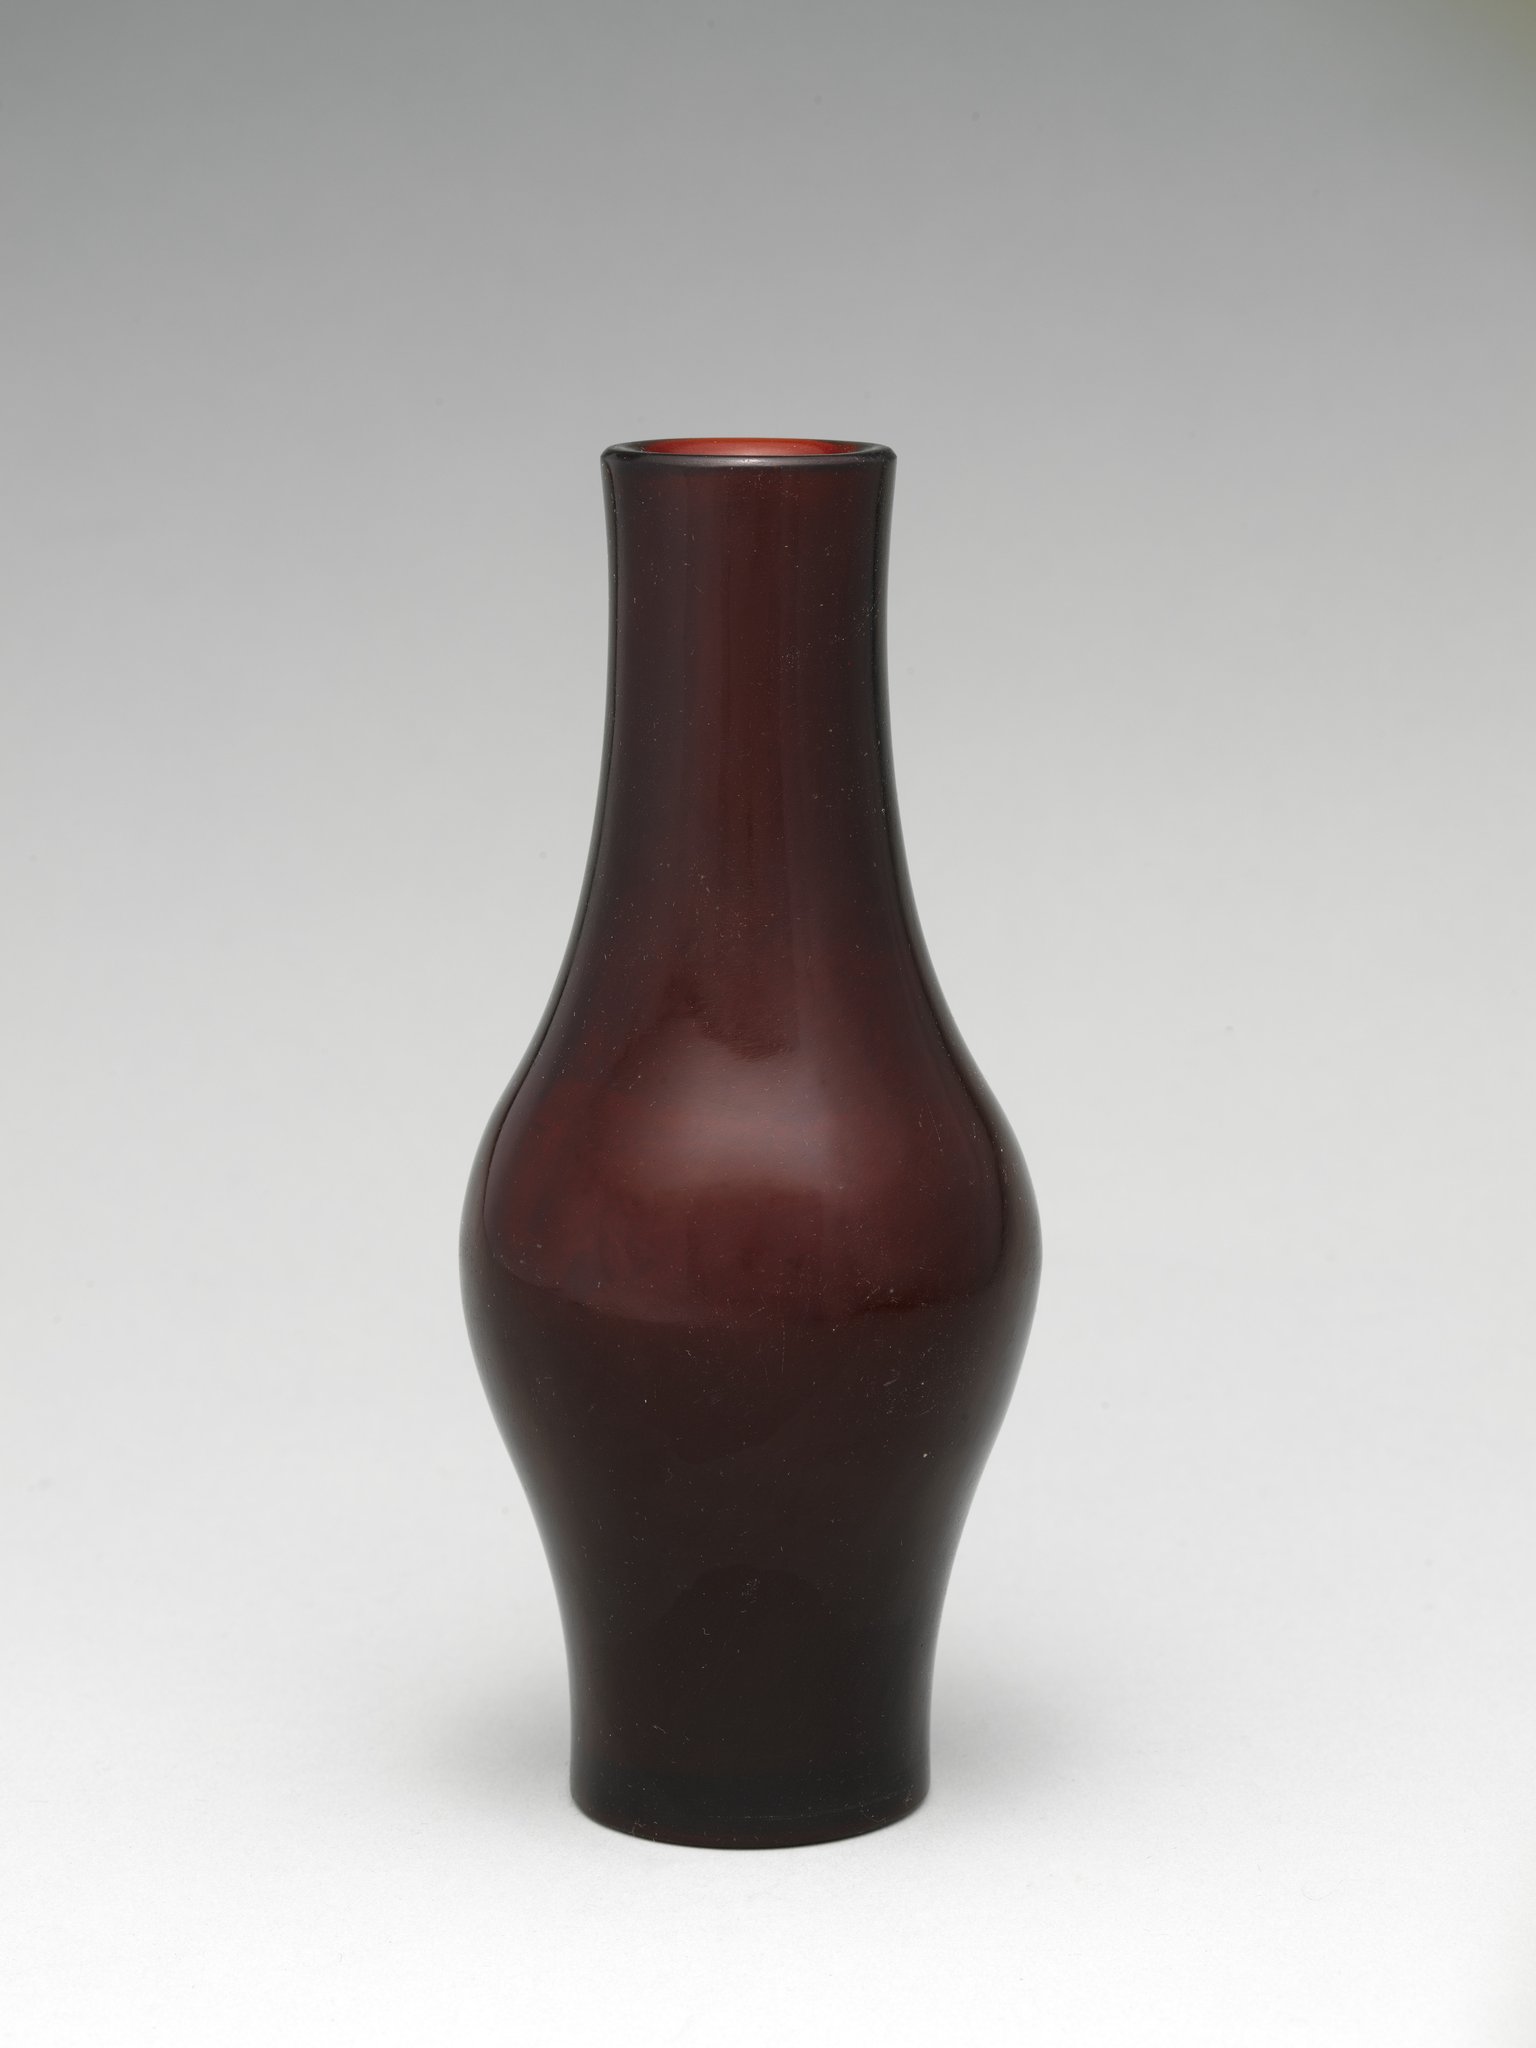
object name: vase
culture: chinese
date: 1723-1735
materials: glass